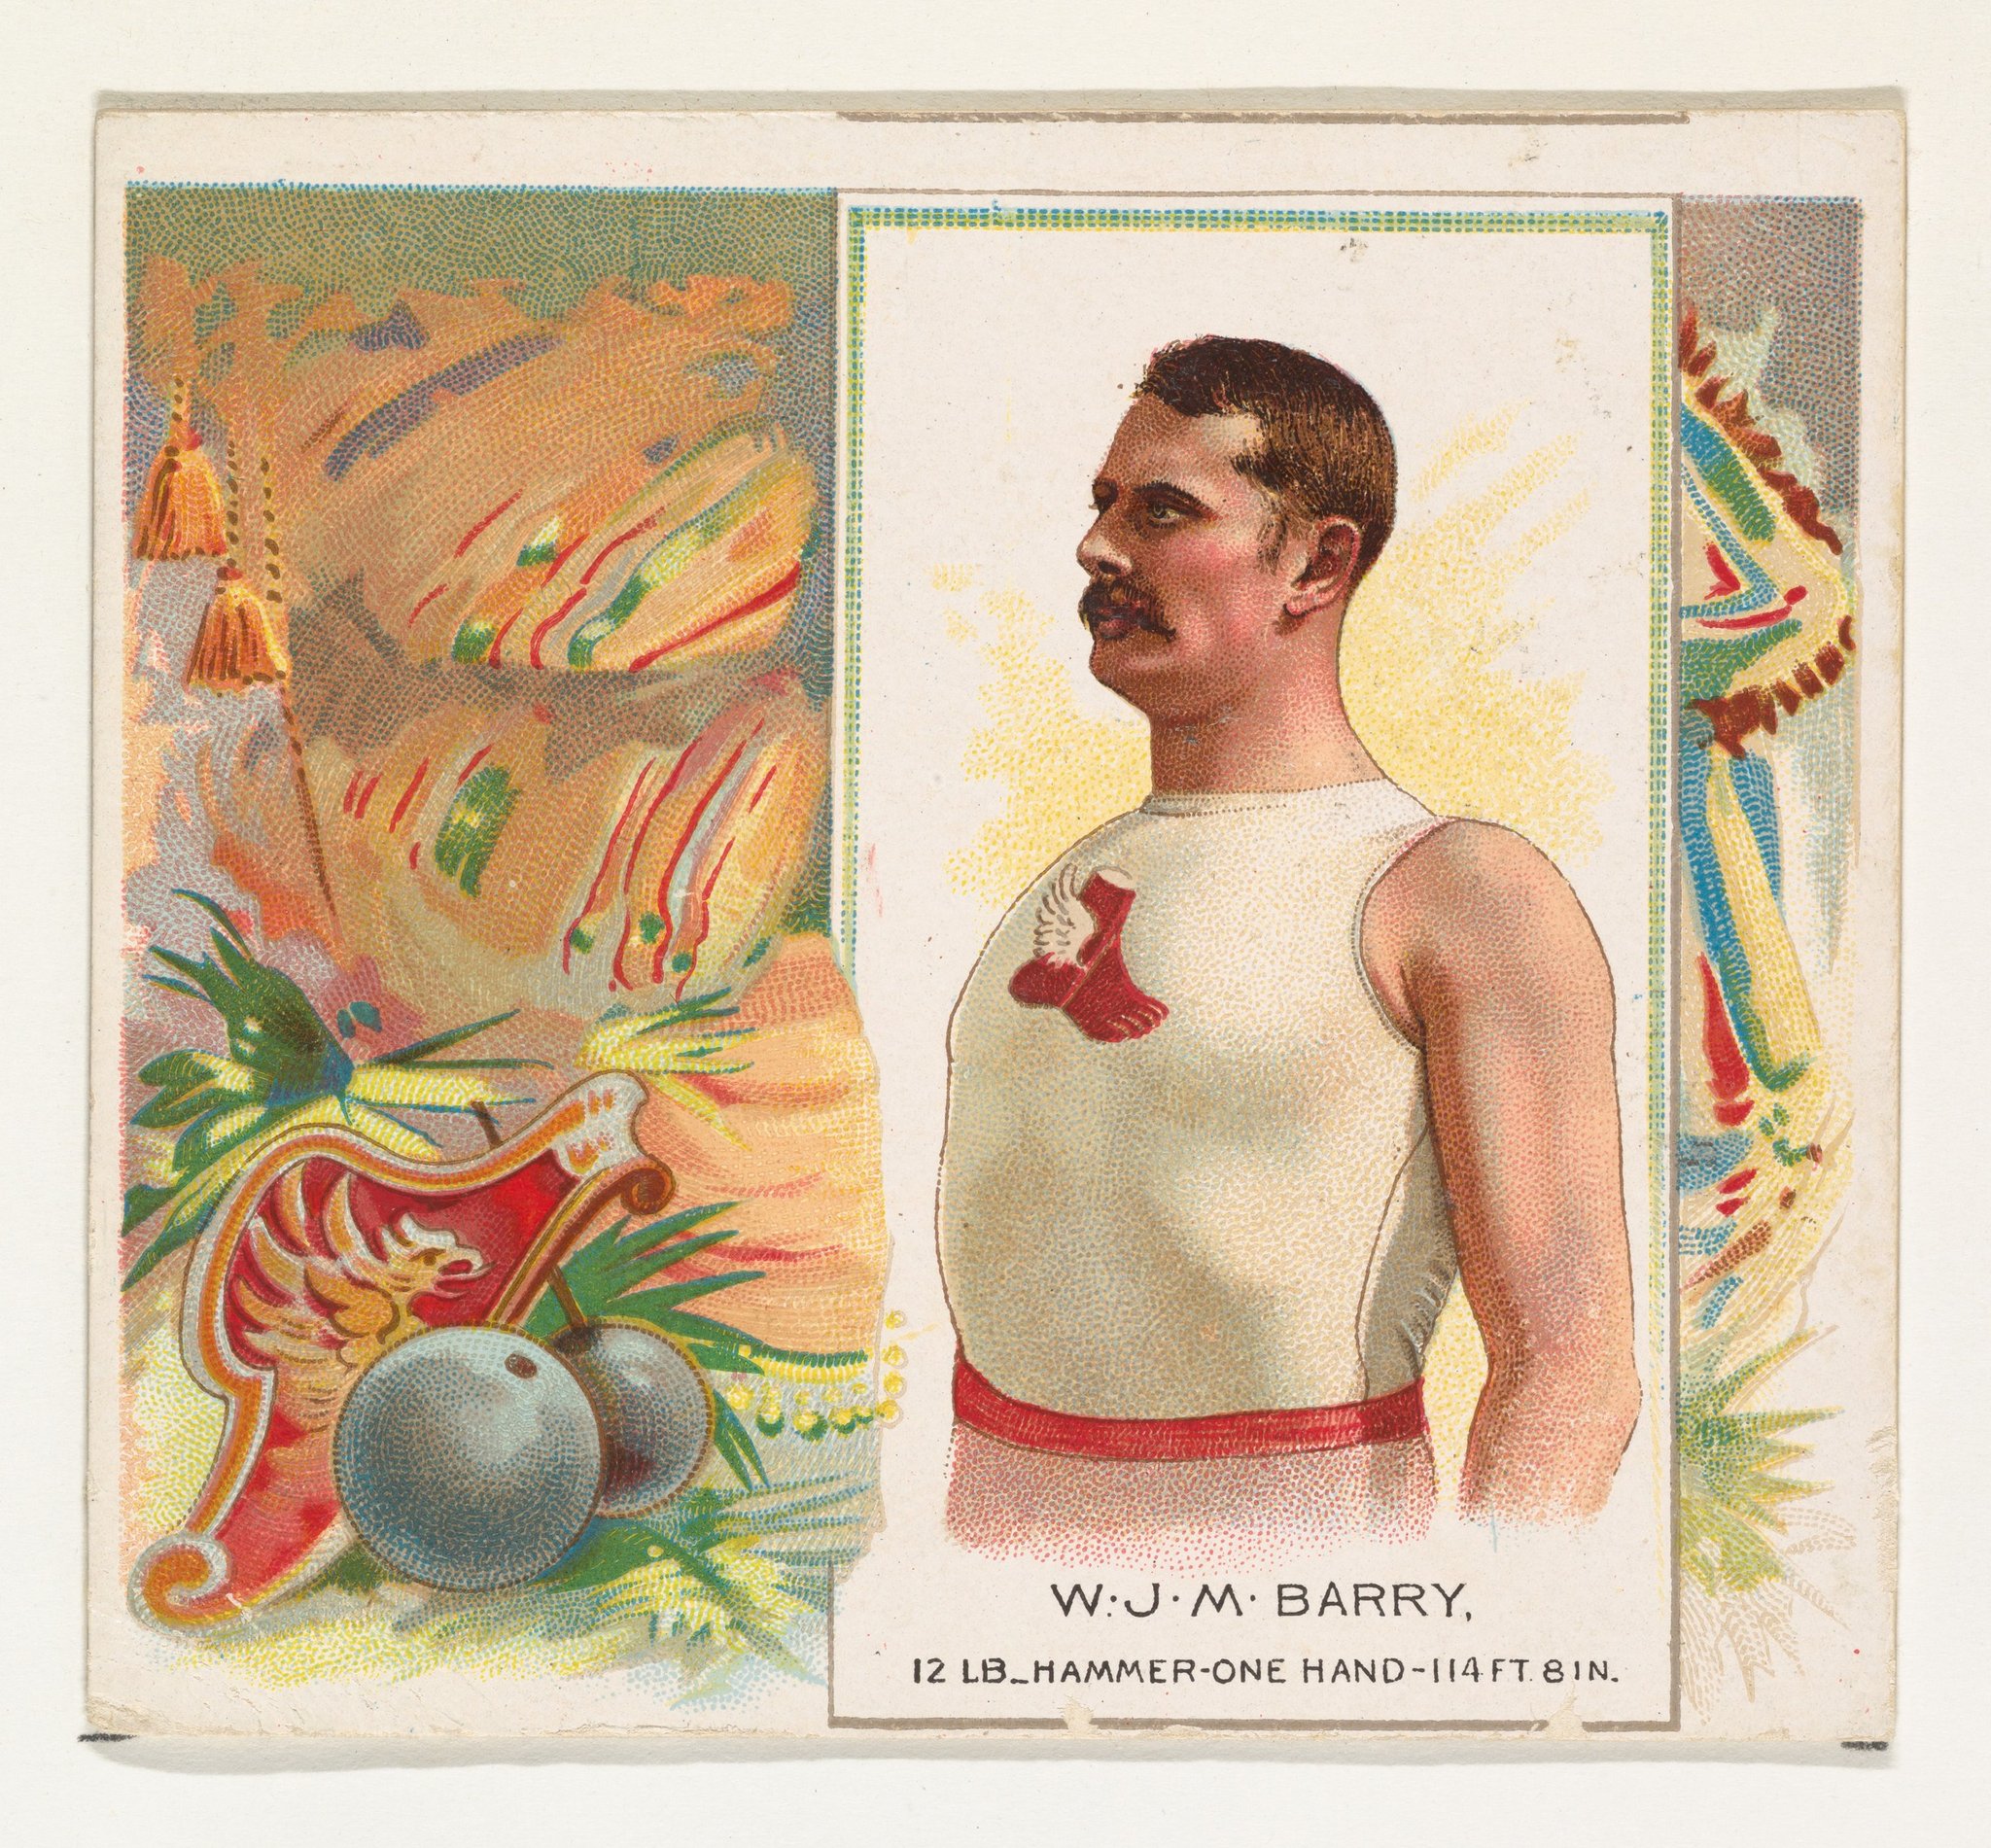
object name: print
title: W.J.M. Barry, Hammer Throw, from World's Champions, Second Series (N43) for Allen & Ginter Cigarettes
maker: allen & ginter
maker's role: publisher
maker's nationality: american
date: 1888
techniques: lithography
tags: men,profiles,athletes